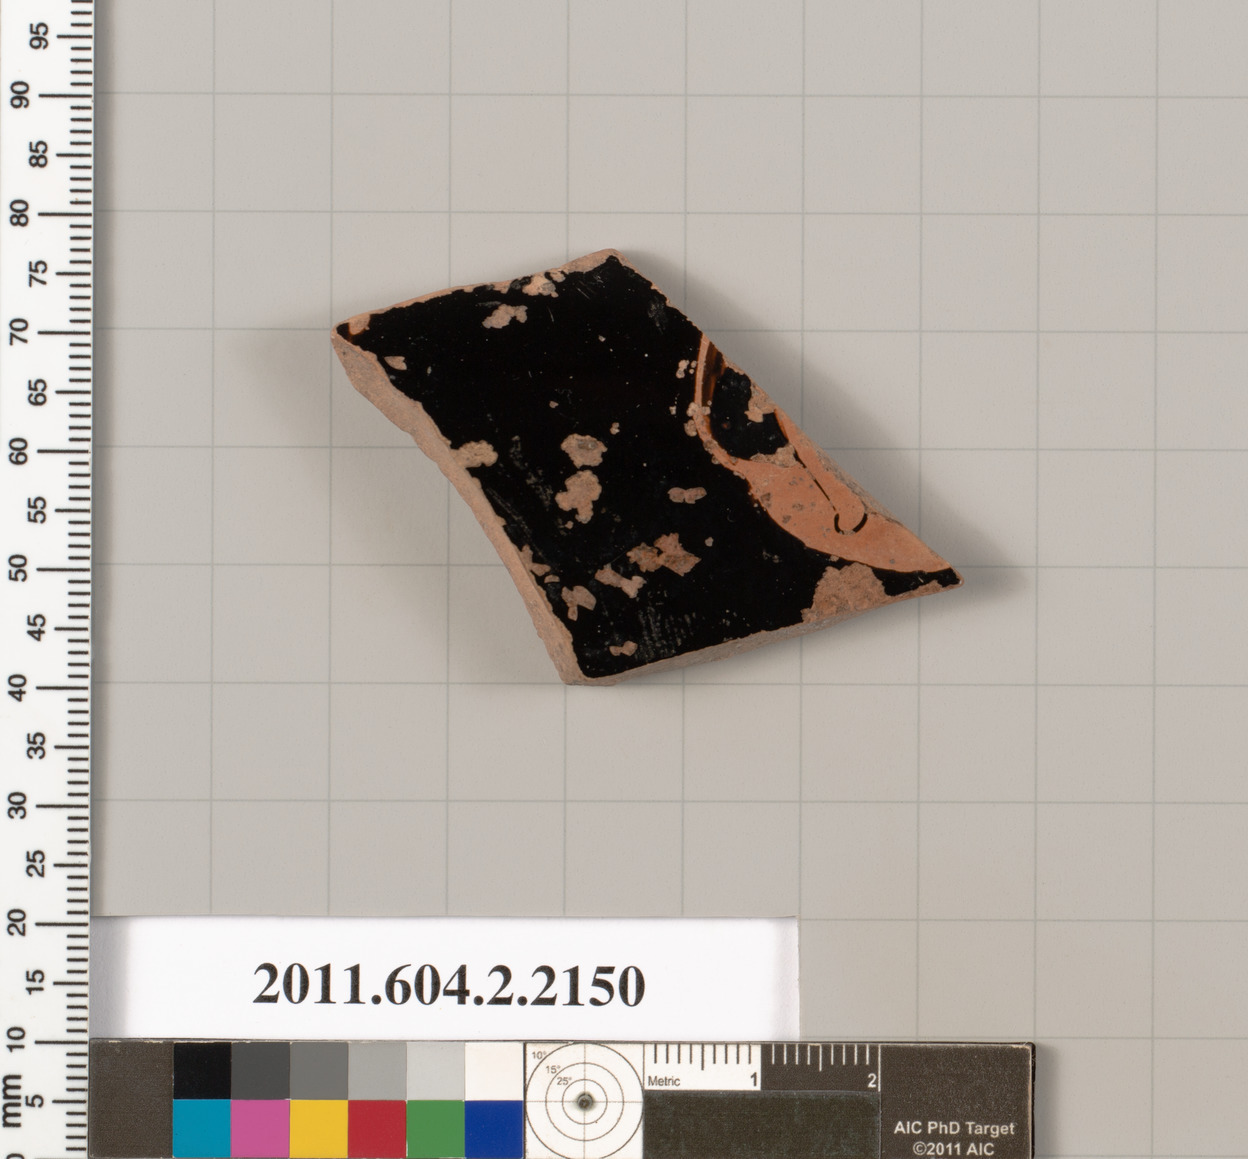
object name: pot fragment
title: Terracotta fragment of a pot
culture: greek, attic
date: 475-451 BCE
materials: terracotta